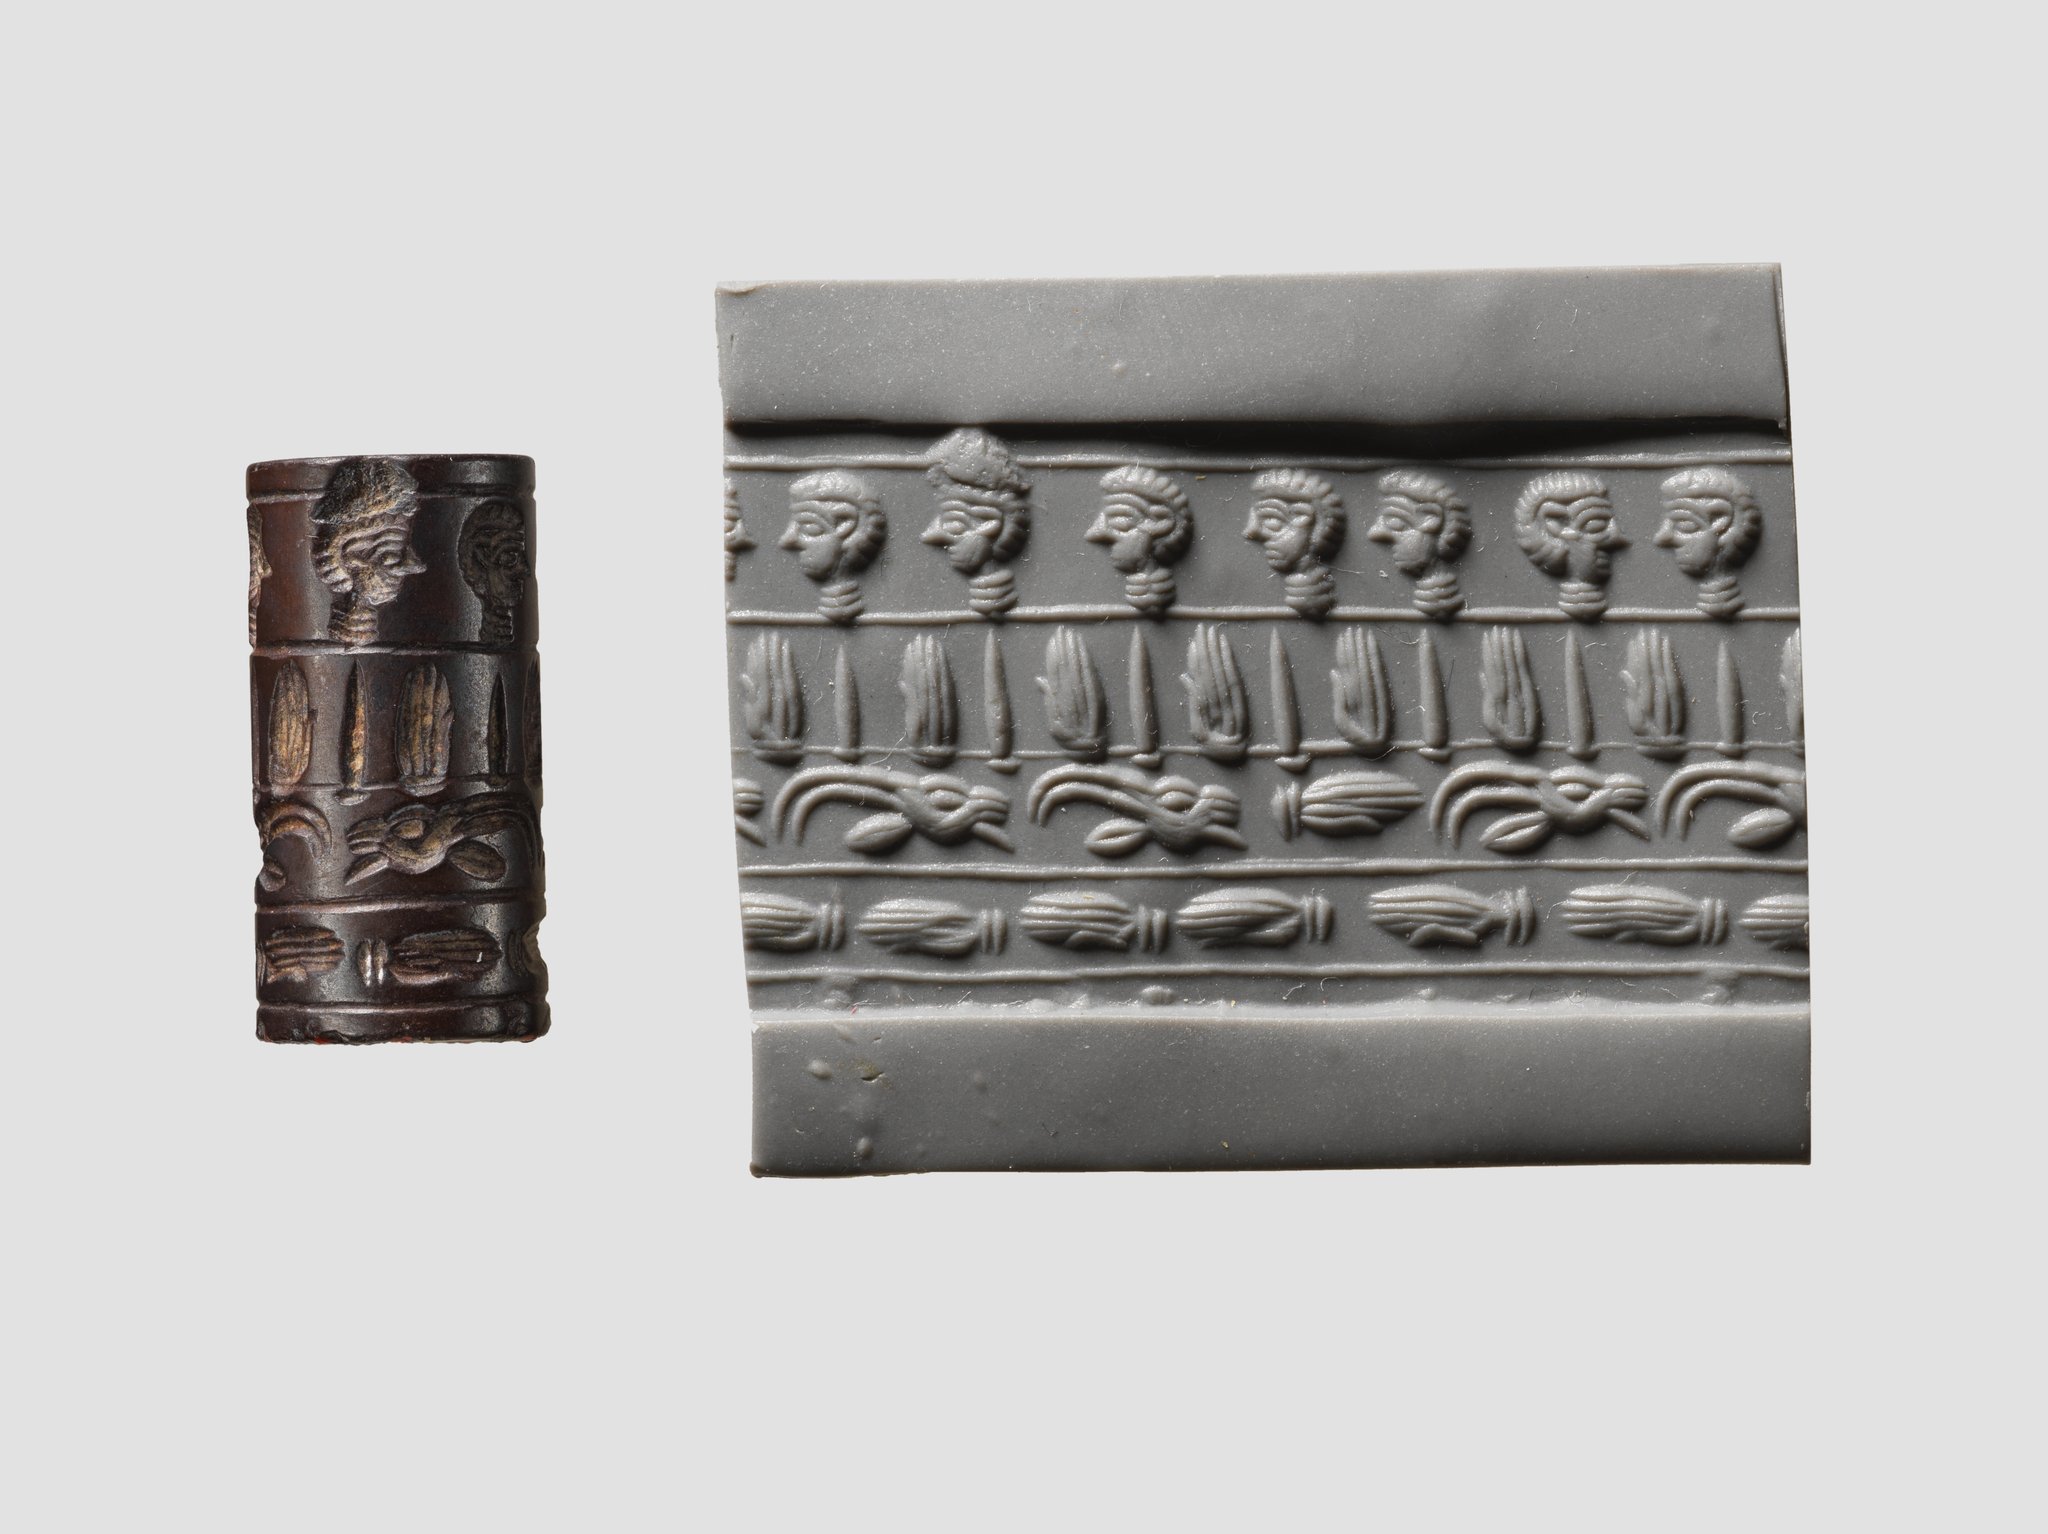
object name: cylinder seal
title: Cylinder seal and modern impression: four registers: hands, human and goat heads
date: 1720-1650 BCE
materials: mineral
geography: syria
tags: hands,goats